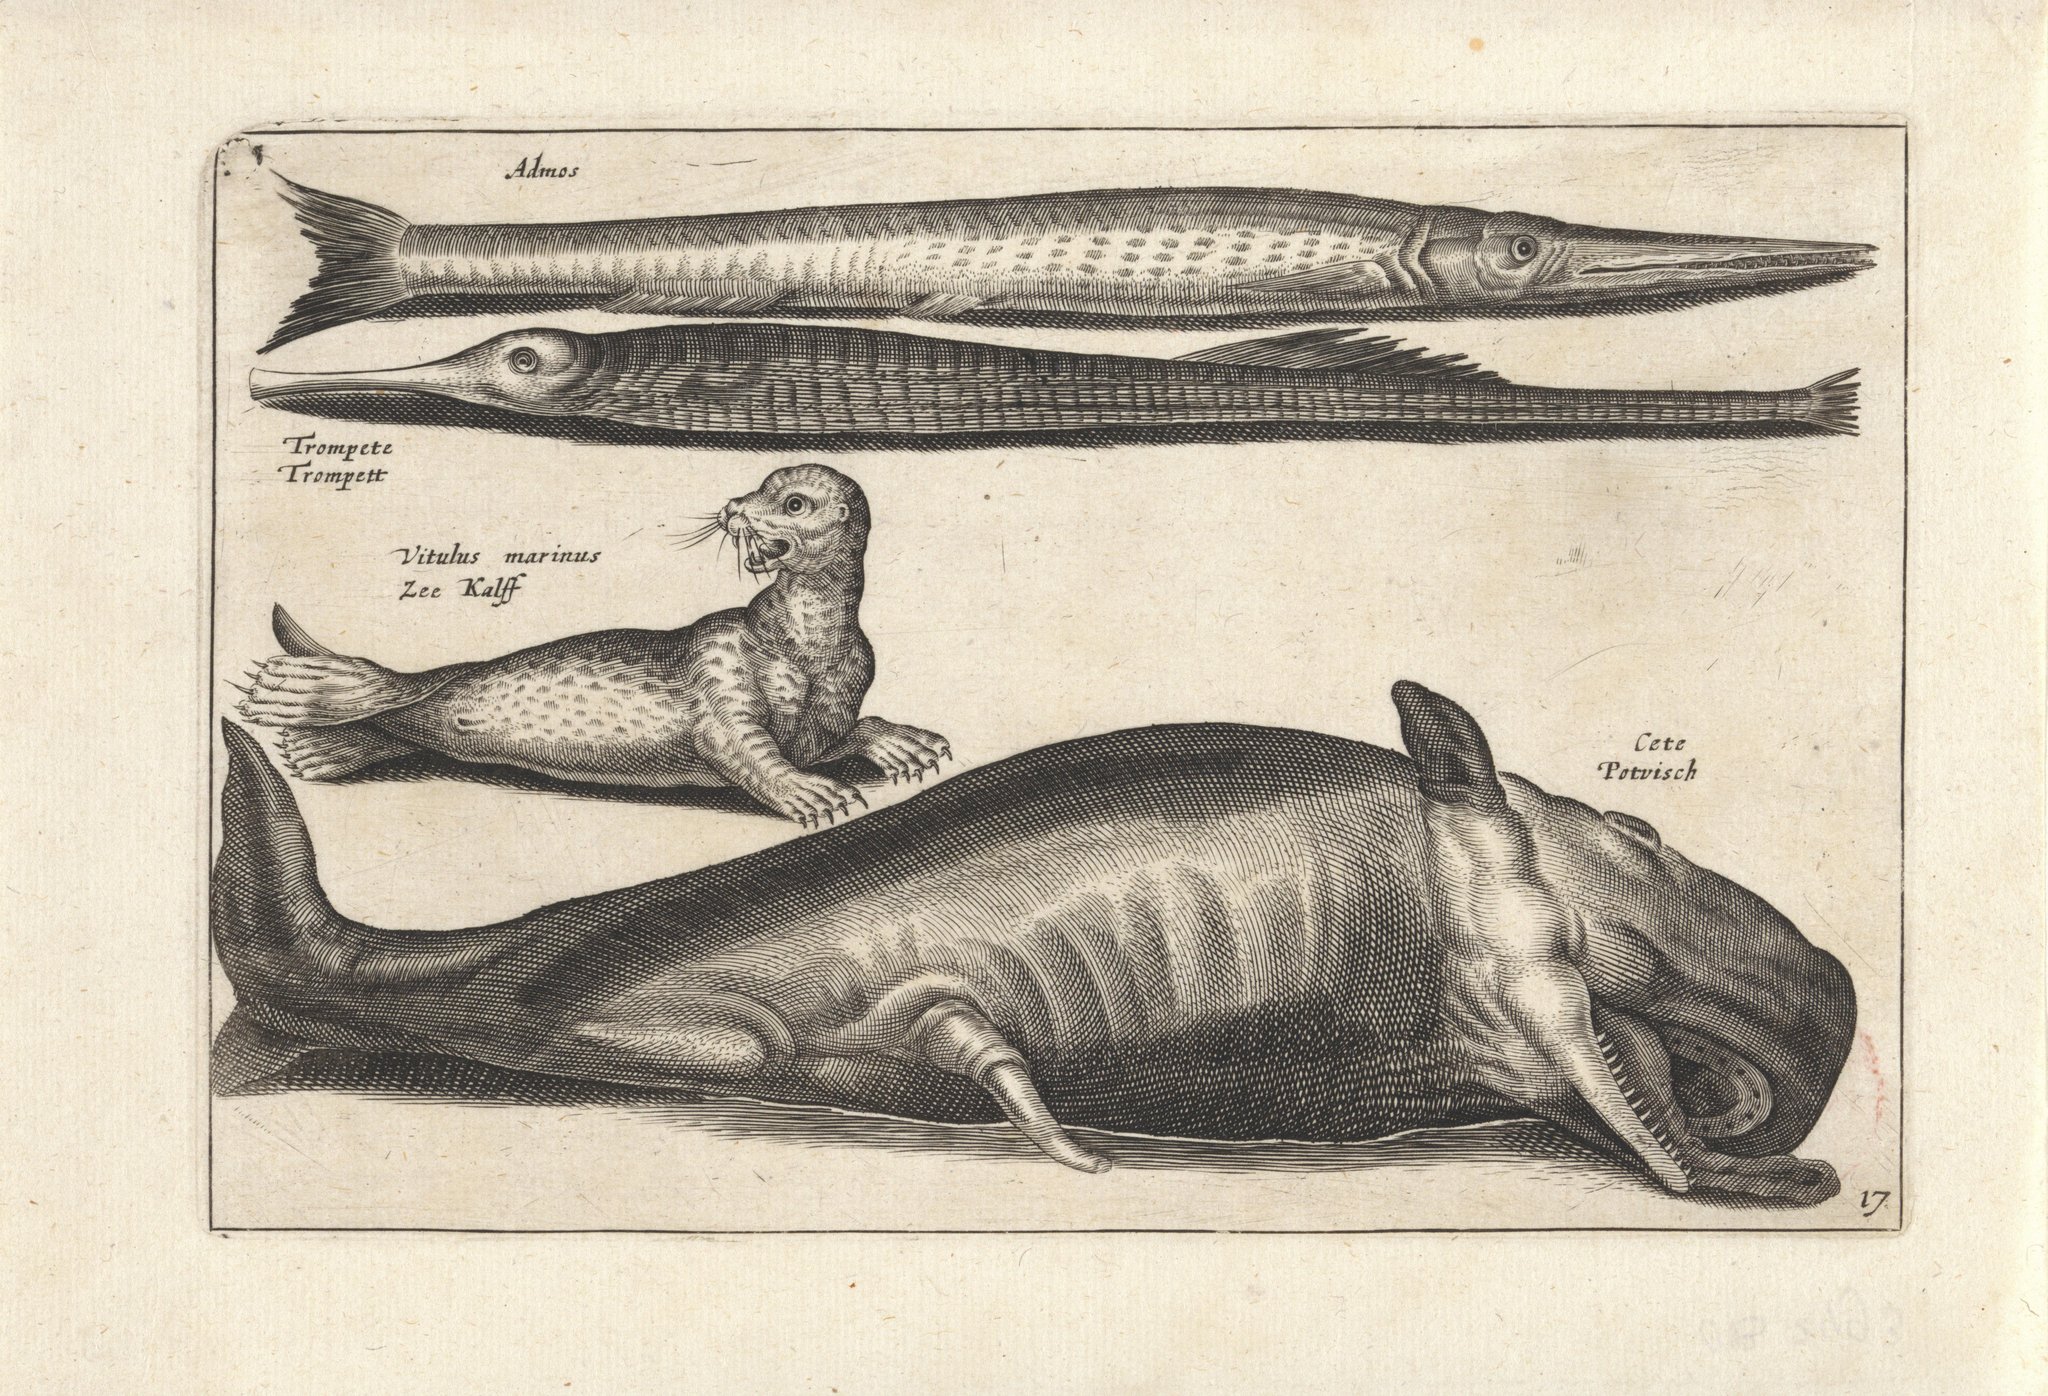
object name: print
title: Potvis en drie zeedieren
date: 1634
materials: paper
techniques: engraving, etching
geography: amsterdam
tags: fishes, swimming mammals: whale (+ dying animal; death of animal; dead animal), swimming mammals: seal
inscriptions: collector's mark: Lugt 240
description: Een potvis, een jonge zeehond, een trompetvis en een andere vis. Elke vis is voorzien van zijn naam. De prent maakt deel uit van een serie met vissen als onderwerp.